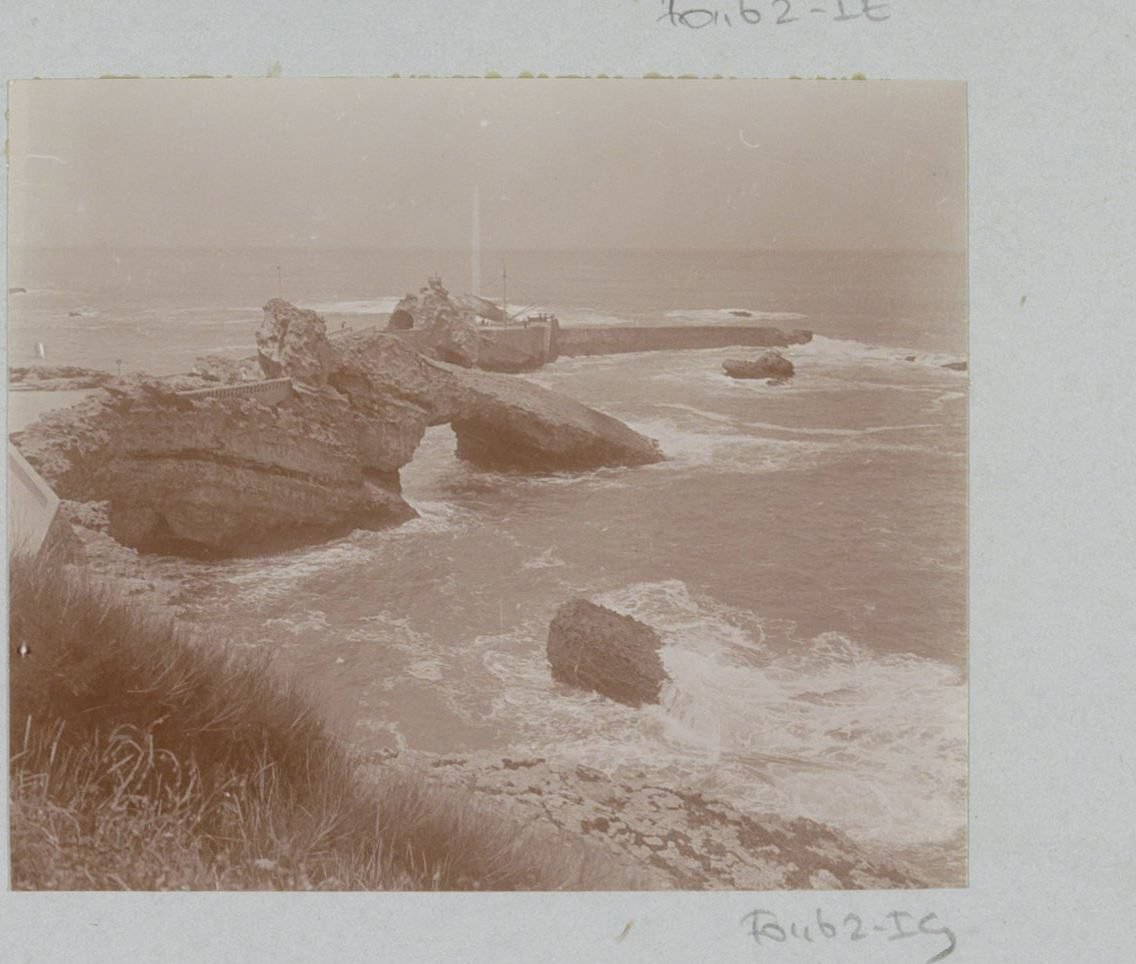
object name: photograph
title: Rotspartij in zee, vermoedelijk aan de Franse kust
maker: Anonymous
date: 1905-1910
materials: paper, photographic support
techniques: gelatin silver print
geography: southern france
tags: coastal cliff or crag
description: Onderdeel van Fotoalbum van een Franse amateurfotograaf met bezienswaardigheden in Frankrijk, Zwitserland en Italië.